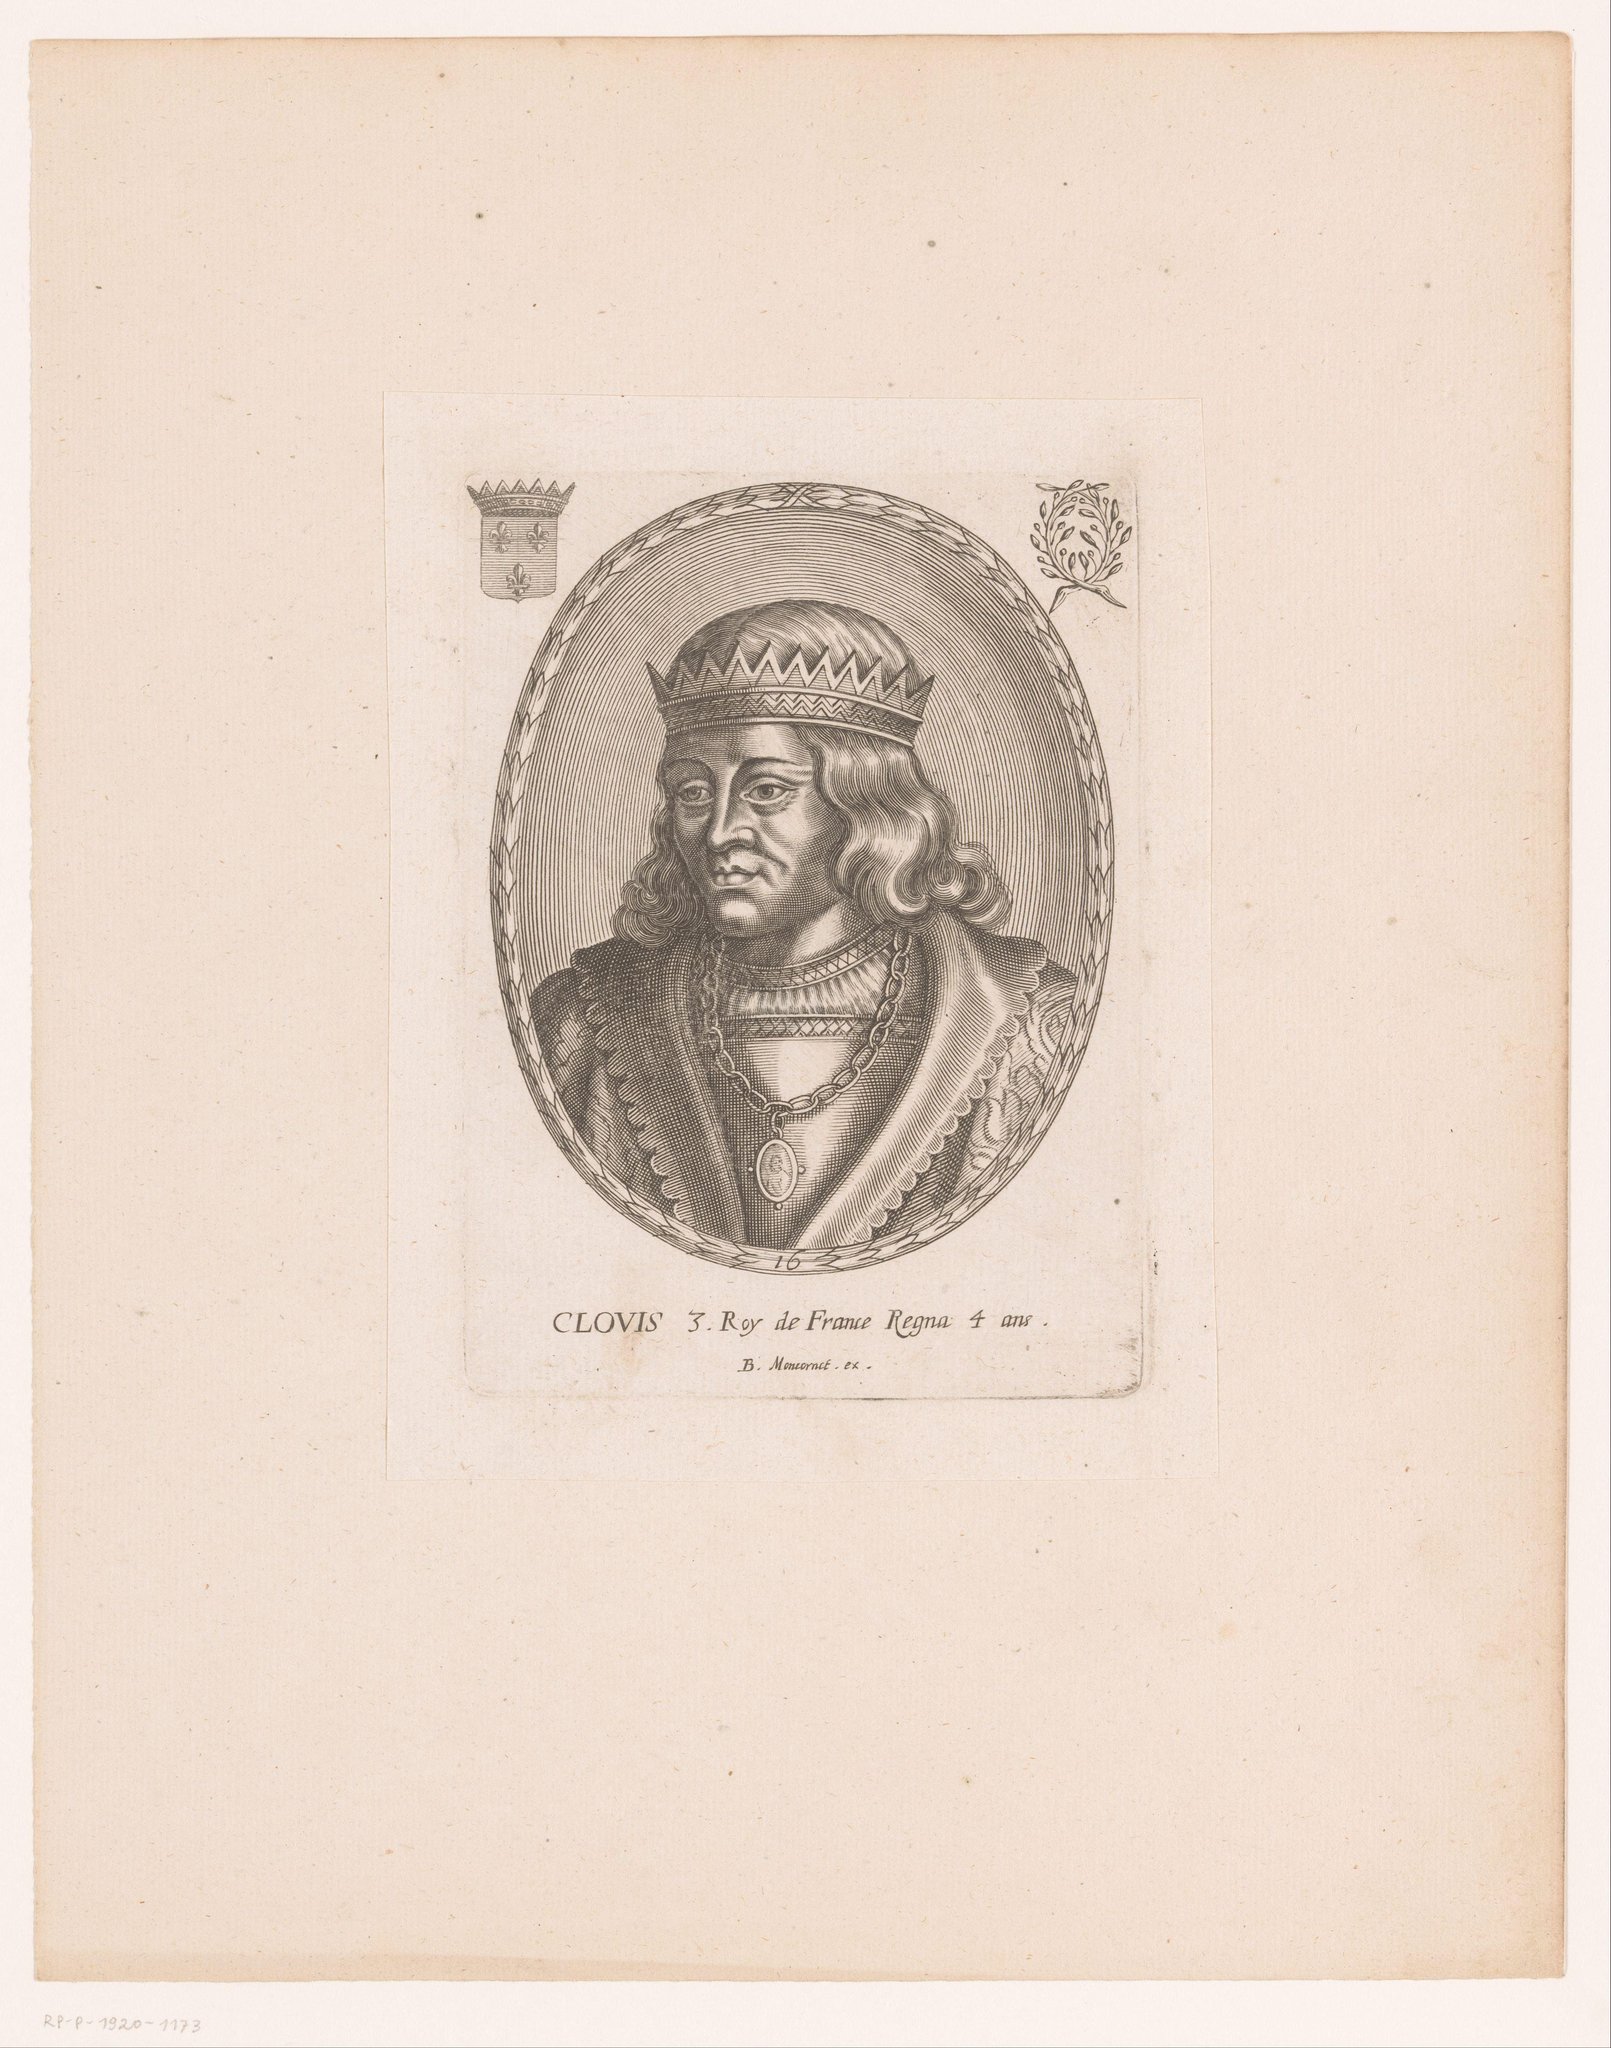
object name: print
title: Portret van Clovis III, koning der Franken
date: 1610-1668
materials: paper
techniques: engraving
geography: paris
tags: historical persons, king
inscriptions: collector's mark: Lugt 2228